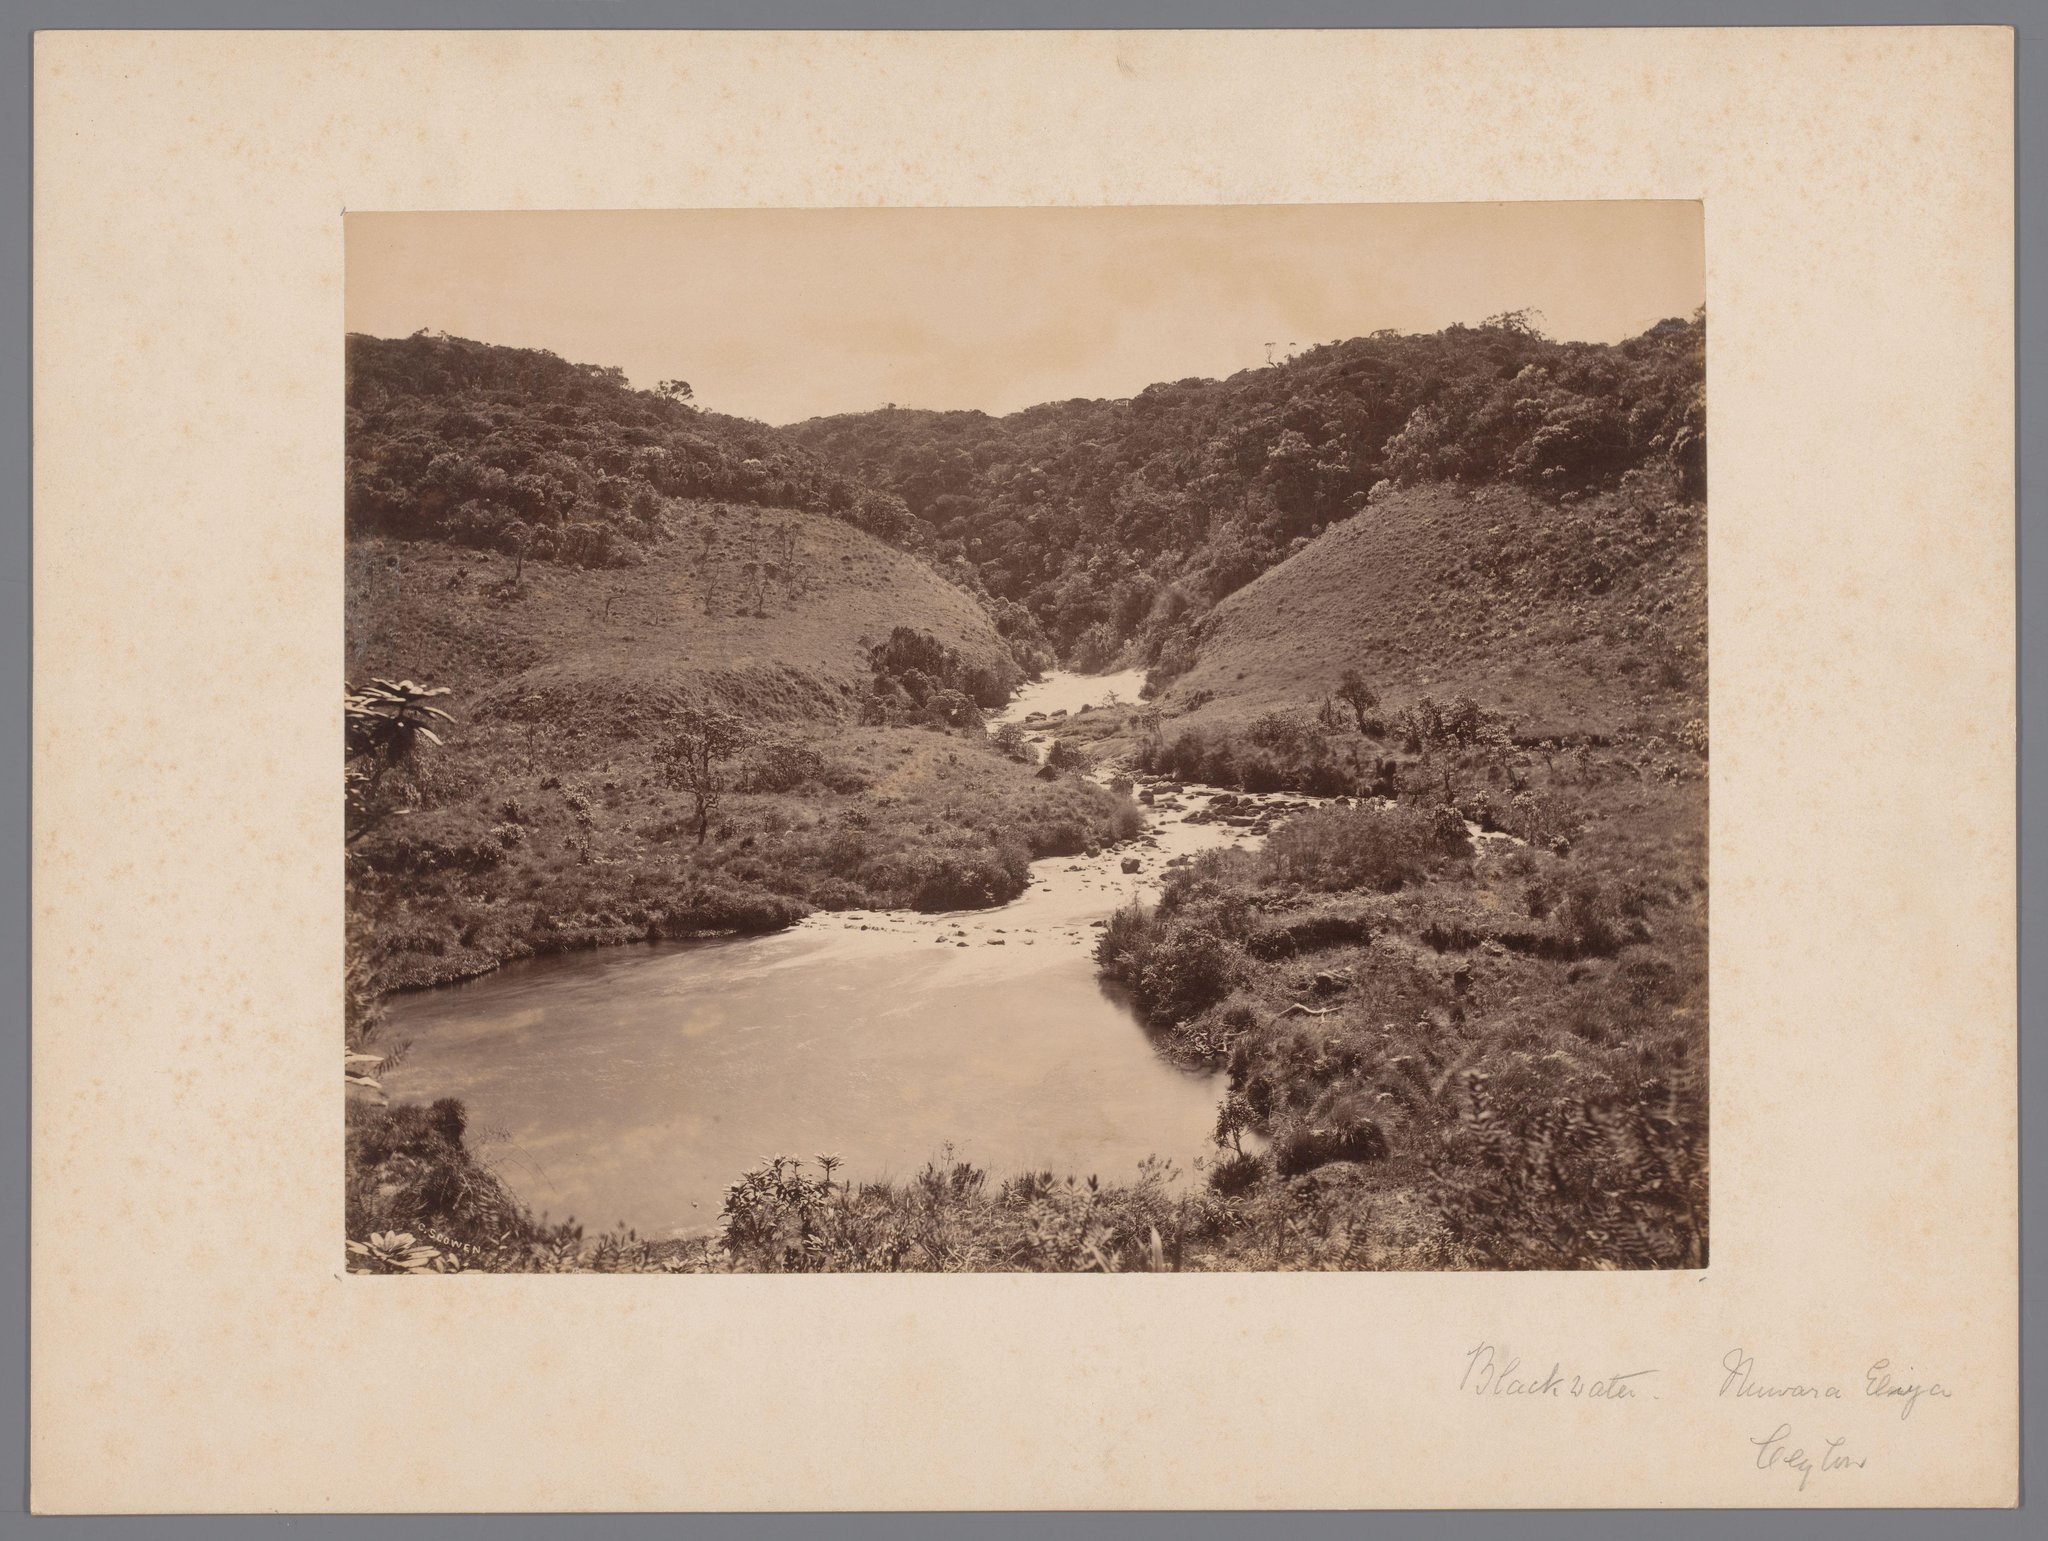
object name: photograph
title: Landscape near Nuwara Eliya, Sri Lanka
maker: charles t. scowen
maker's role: fotograaf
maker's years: 1852-1948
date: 1870-1890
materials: cardboard, photographic support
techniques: albumen print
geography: nuwara eliya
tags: sri lanka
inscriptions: title: ‘Blackwater. Nuwara Eliya/ Ceylon’, name: ‘C. Scowen’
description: Gezicht op een heuvelachtig landschap met een kalm stromende rivier en lage vegetatie. Nuwara Eliya is een stad in Centraal-Sri Lanka. Deze stad in Ceylon werd in 1847 door de Engelse ontdekkingreiziger Samuel Baker (1821-1893) gesticht.